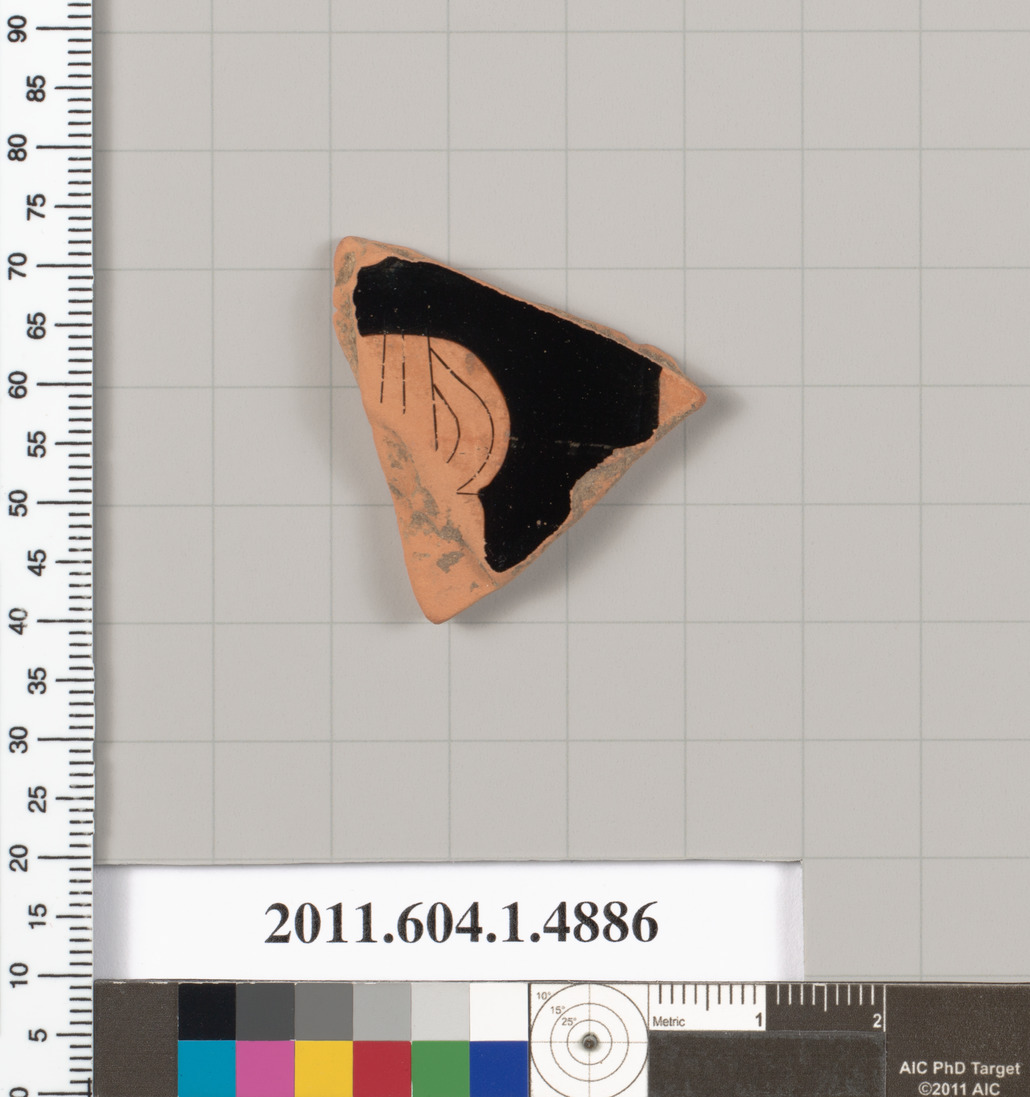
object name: kylix fragment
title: Terracotta fragment of a kylix (drinking cup)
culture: greek, attic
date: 480-470 BCE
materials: terracotta